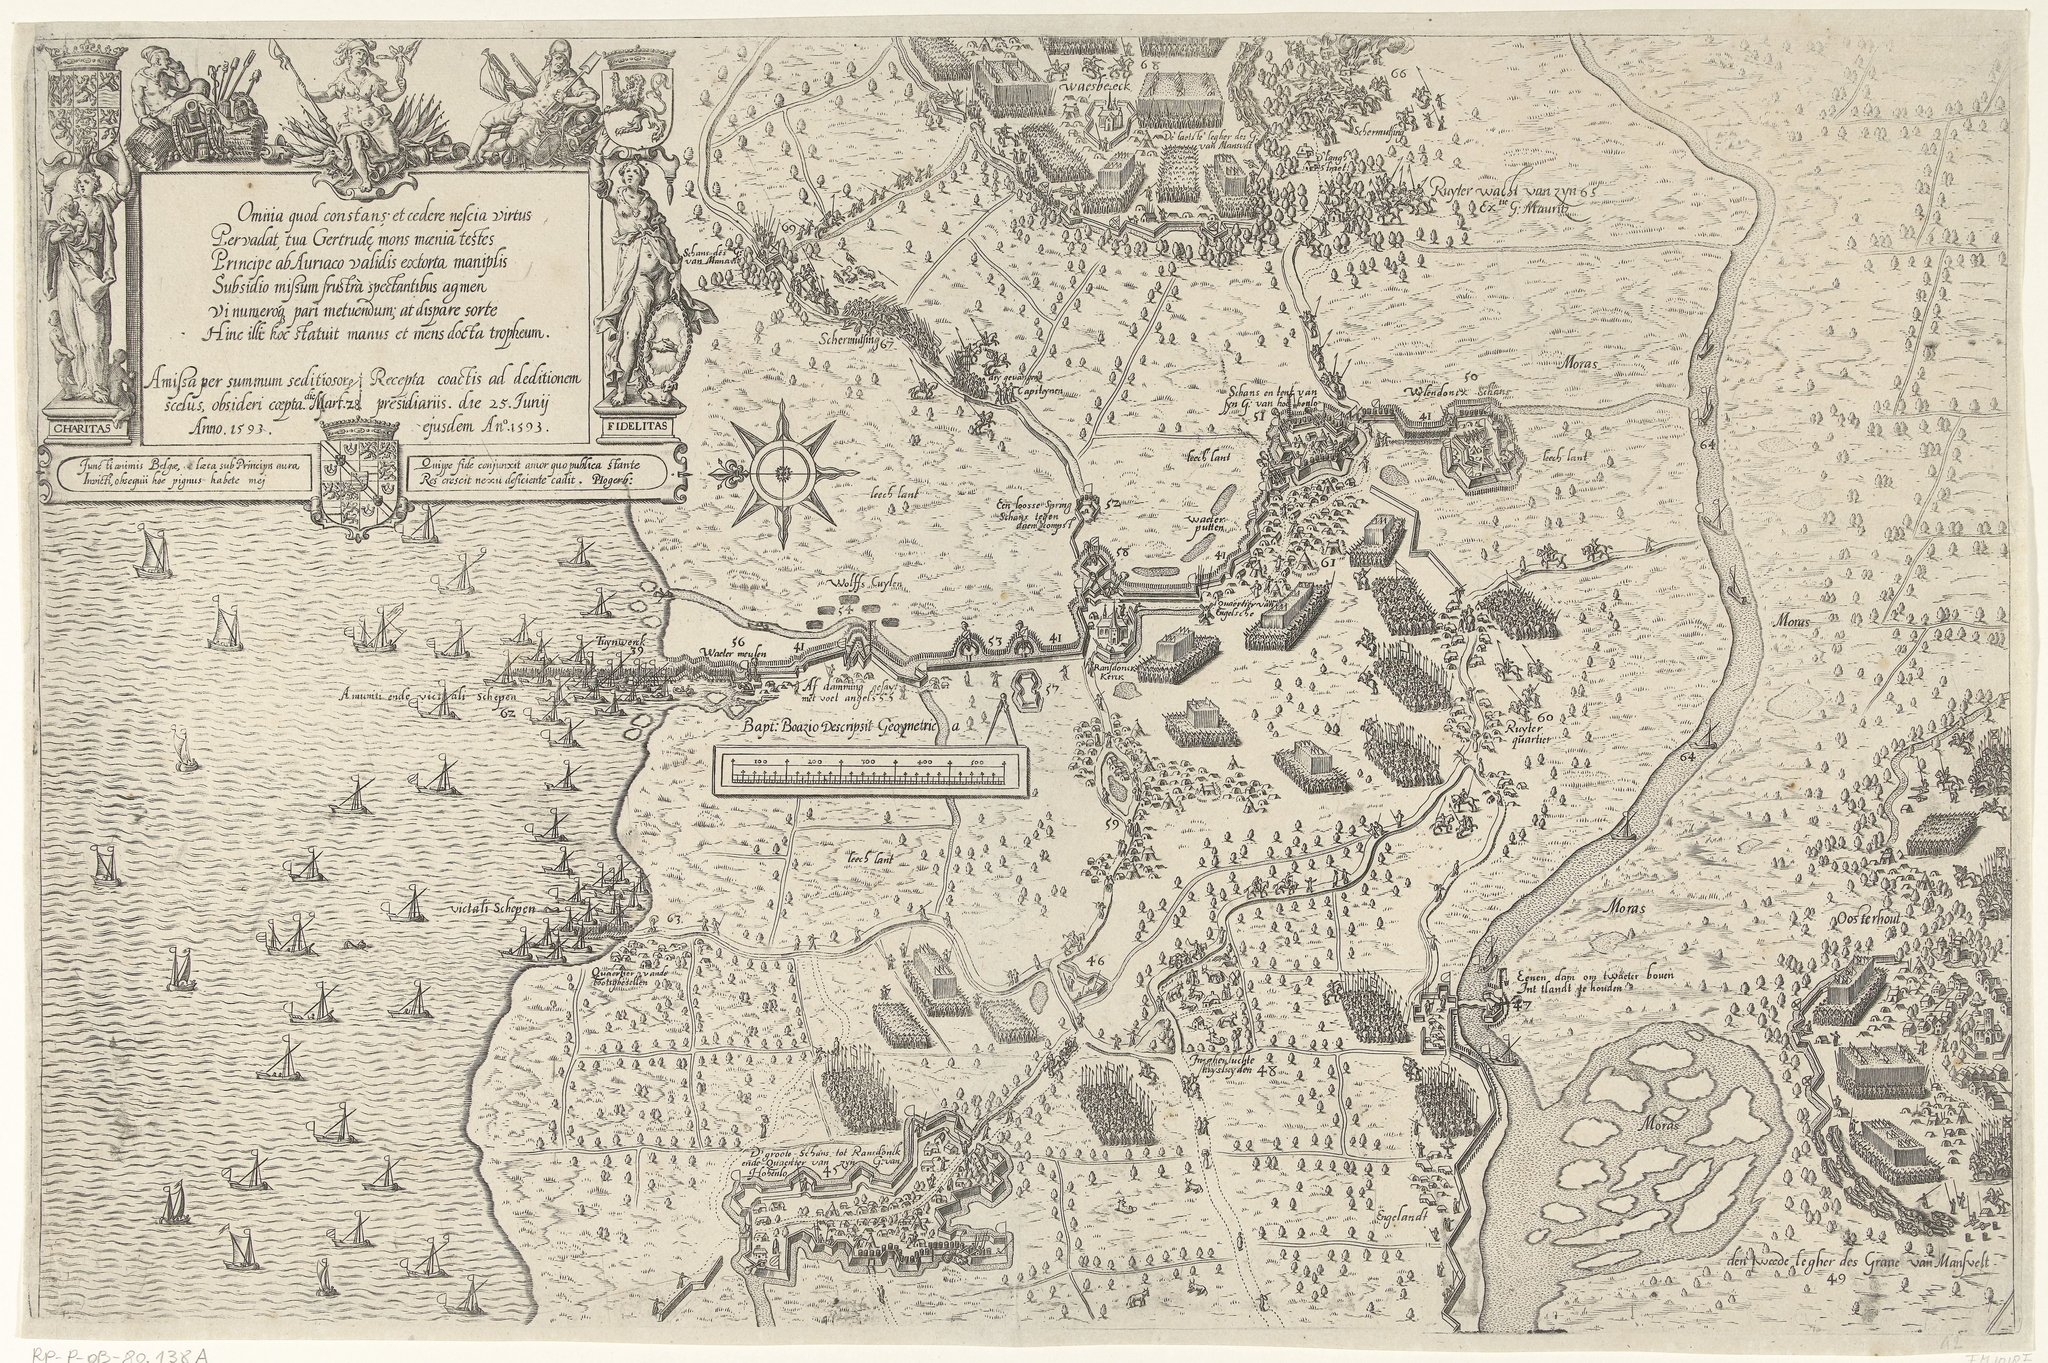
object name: print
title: Beleg en verovering van Geertruidenberg (bovenste blad), 1593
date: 1593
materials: paper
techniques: engraving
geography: northern netherlands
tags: the hague, maurice (prince of orange), charity, 'caritas'; 'carità' (ripa) ~ one of the three theological virtues, maps of separate countries or regions, fidelity; 'fedeltà' (ripa), siege, position war, geertruidenberg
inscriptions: date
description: Kaart van de belegering en verovering van Geertruidenberg door het Staatse leger onder prins Maurits, 28 maart - 26 juni 1593. Bovenste van twee bladen met links de Biesbos en bovenaan het plaatsje Waspik (Waesbeeck). met de posities van het Spaanse leger onder Peter Ernst, graaf van Mansfeld. Linksboven een cartouche met allegorische figuren Liefde (Charitas) en Trouw (Fidelitas) en wapens en een opschrift van 9 regels en daaronder een vers van 4 regels in het Latijn.